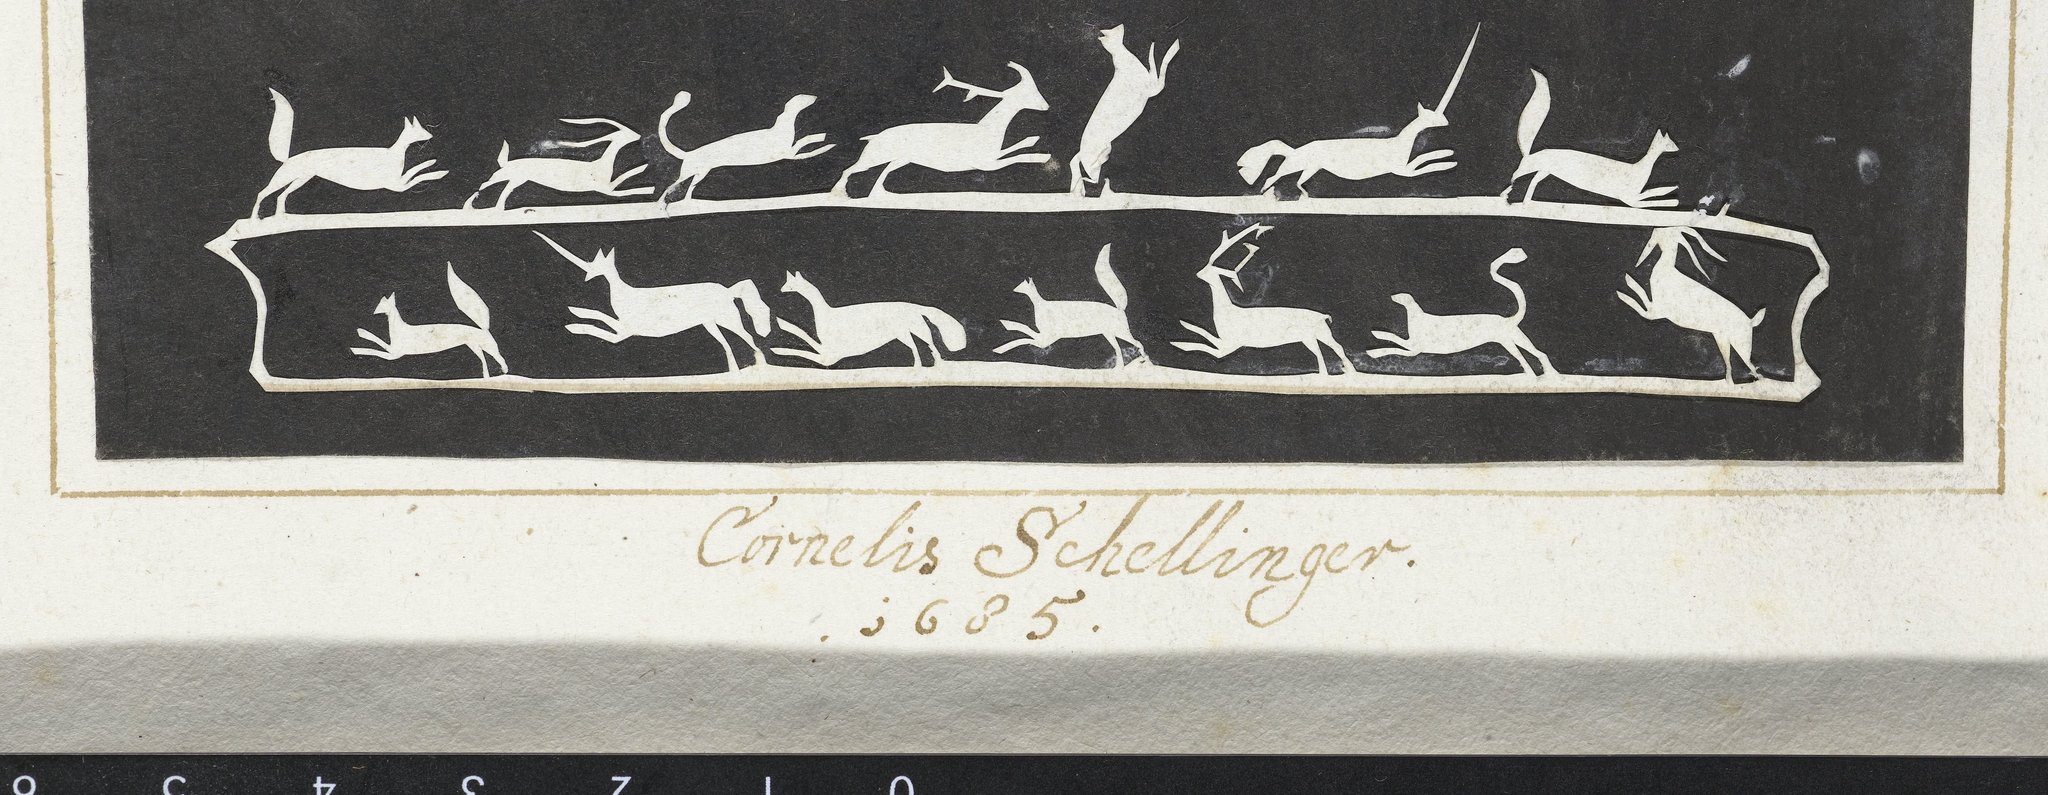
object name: cut paper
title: Dieren in een kring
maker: cornelis schellinger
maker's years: 1672-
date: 1685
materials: paper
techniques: snipping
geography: zwolle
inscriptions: date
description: Wit knipsel op een zwart papier, samen met drie andere knipselkunstwerken op een blad geplakt in het Plakboek.